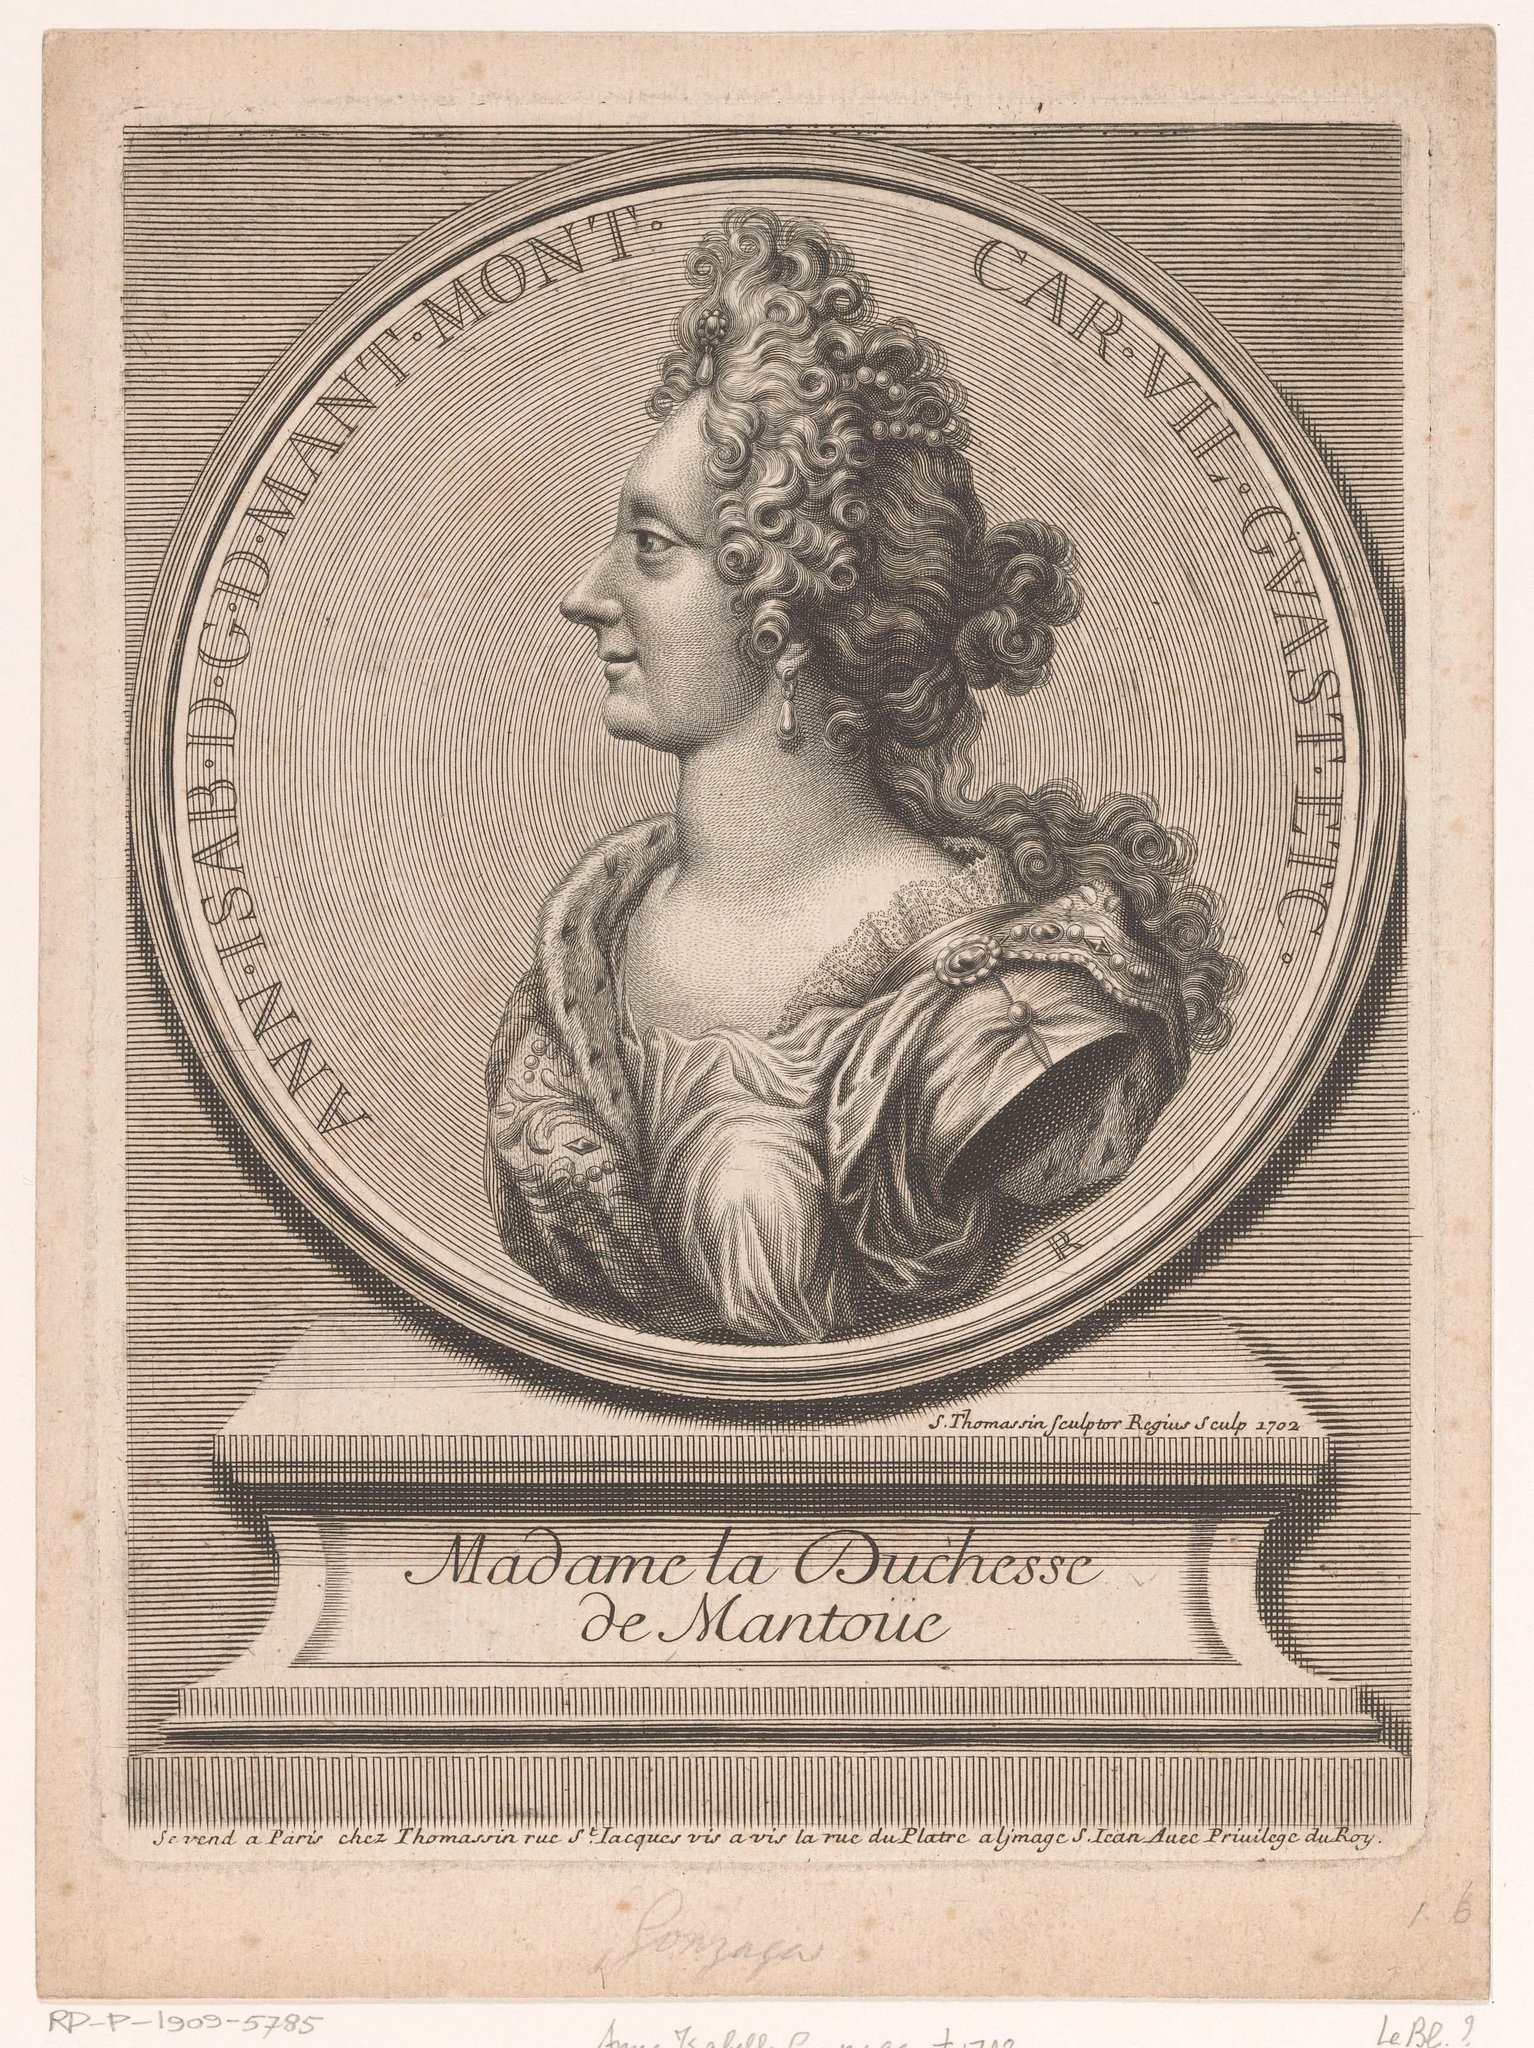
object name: print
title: Portret van Anna Isabella Gonzaga en profil op een medaille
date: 1702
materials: paper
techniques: engraving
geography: france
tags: historical persons, ruler, sovereign - bb - female ruler, medal (considered as a piece of sculpture, regardless of its specific function)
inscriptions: collector's mark: Lugt 2228